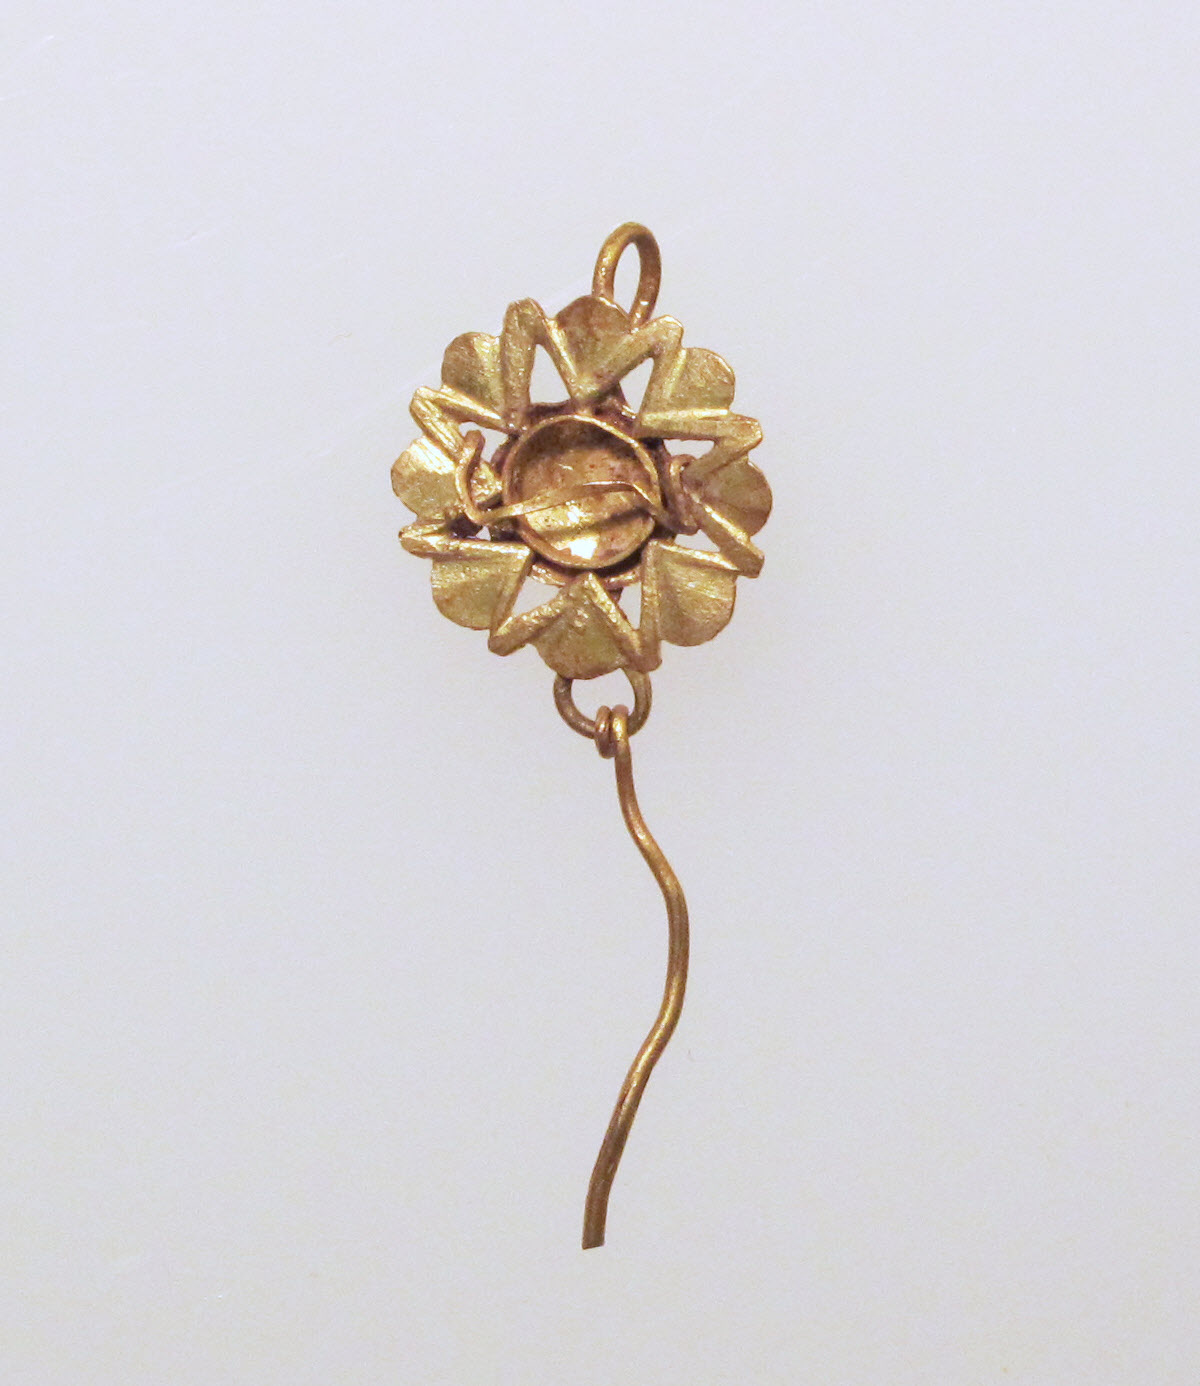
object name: earring with pendant and disc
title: Earring with pendant and perforated disc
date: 7000 BCE-330 CE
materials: gold